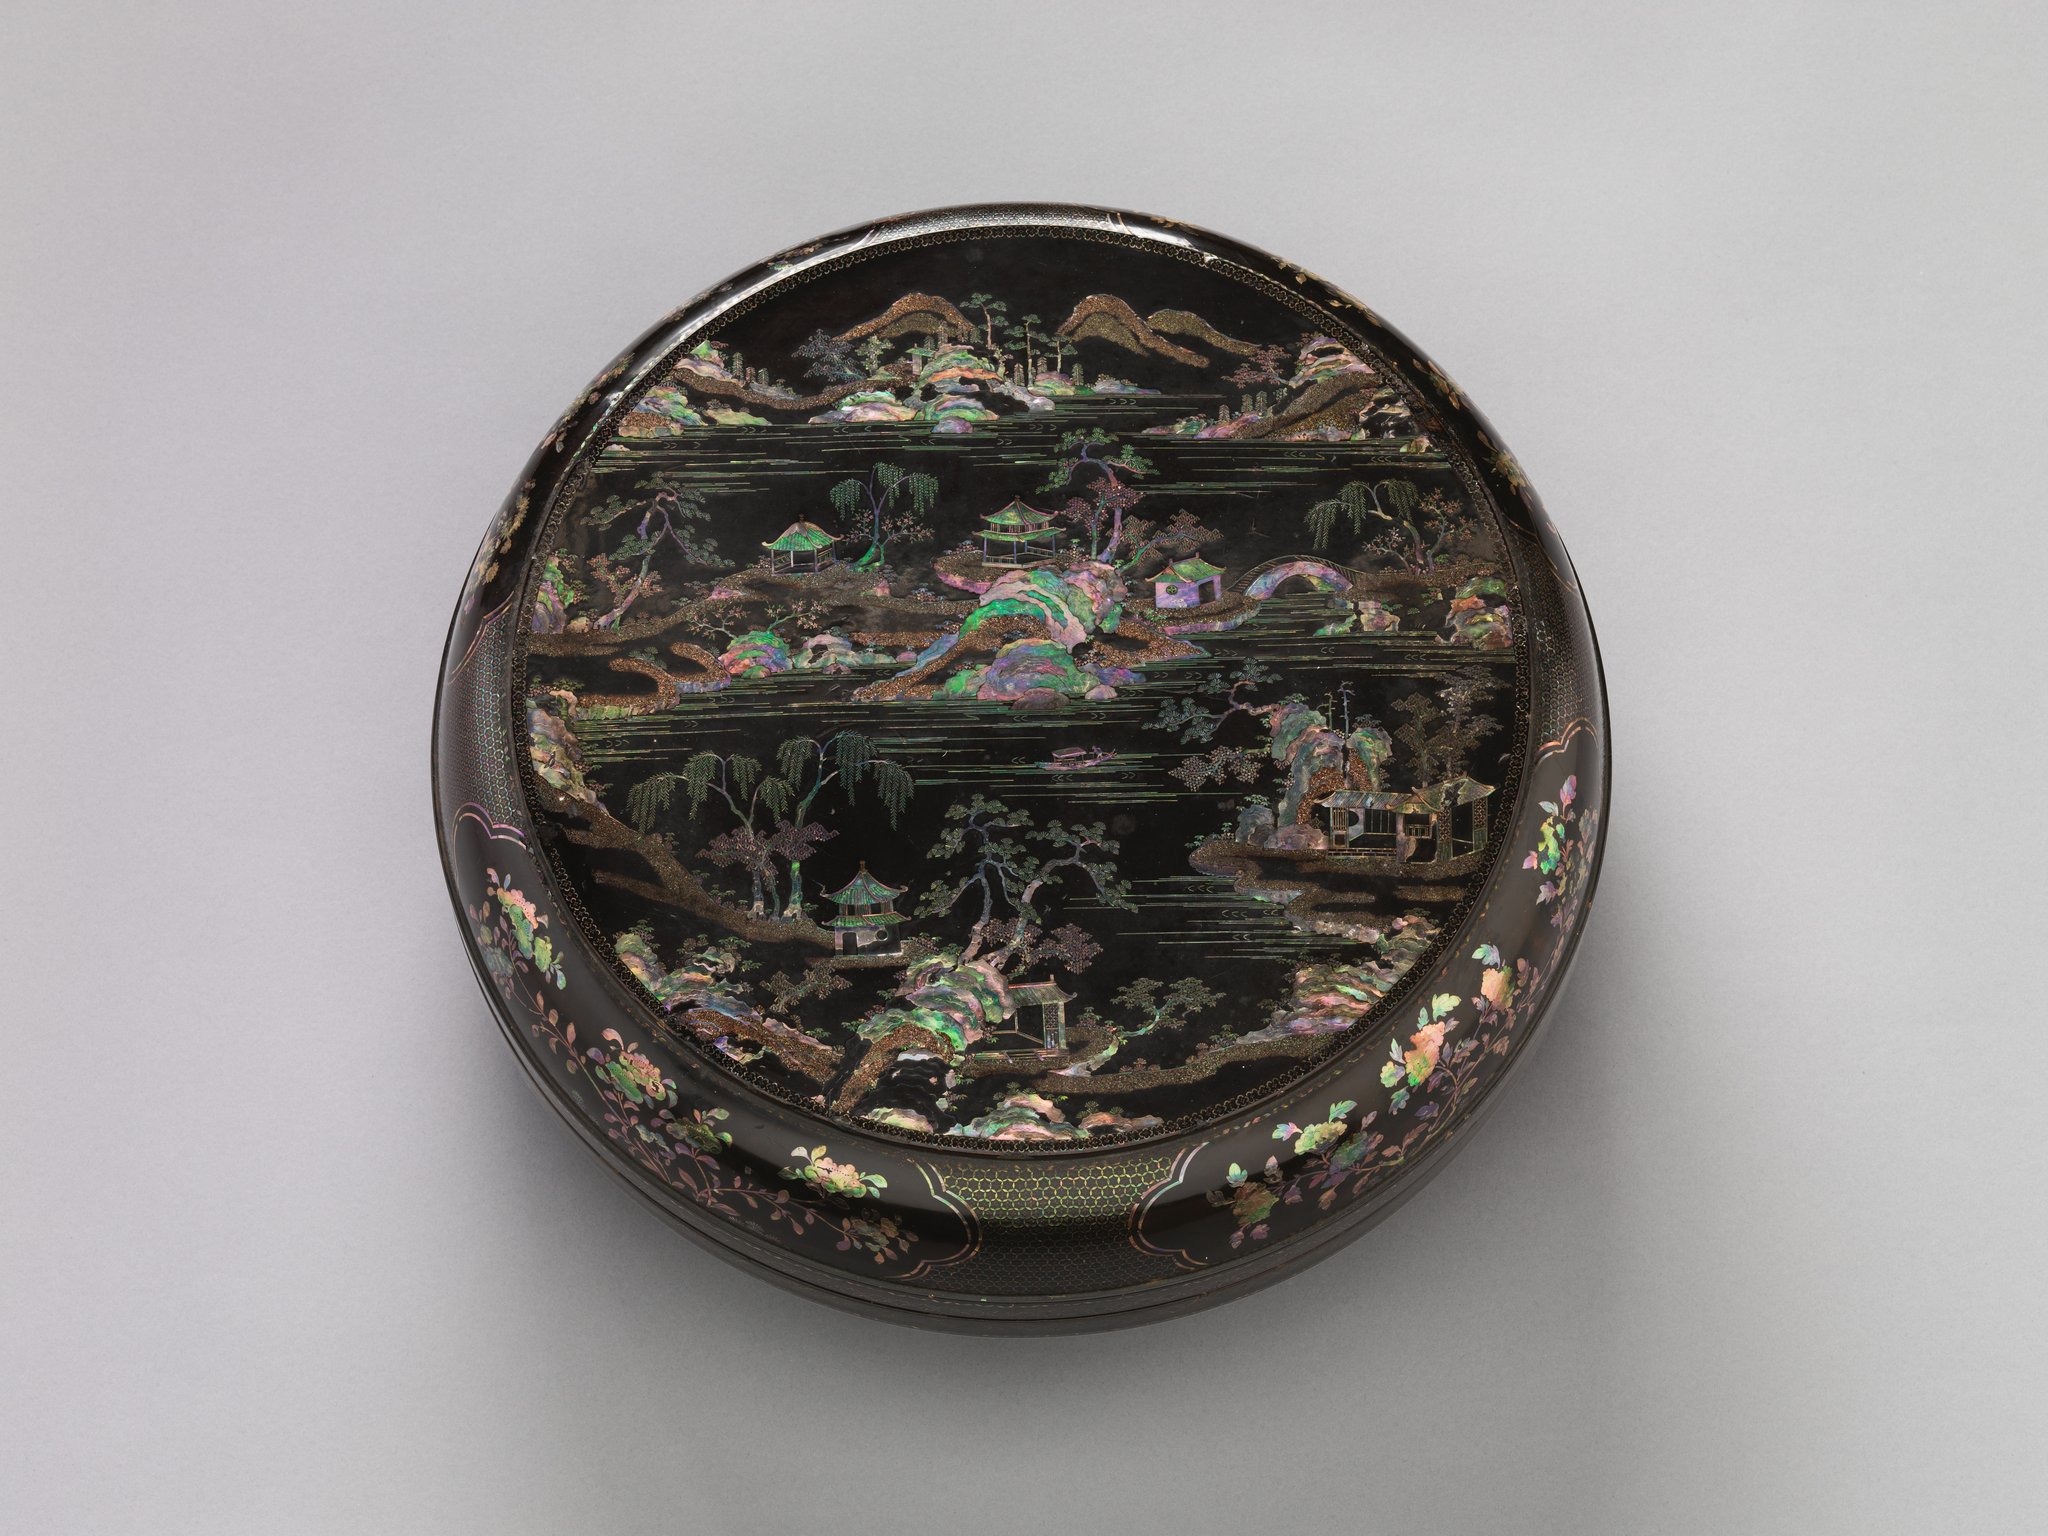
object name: box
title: Round Box with Chinese-Style Landscape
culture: japanese or ryukyuan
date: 1701-1733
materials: lacquer, mother of pearl, metal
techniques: inlay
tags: landscapes